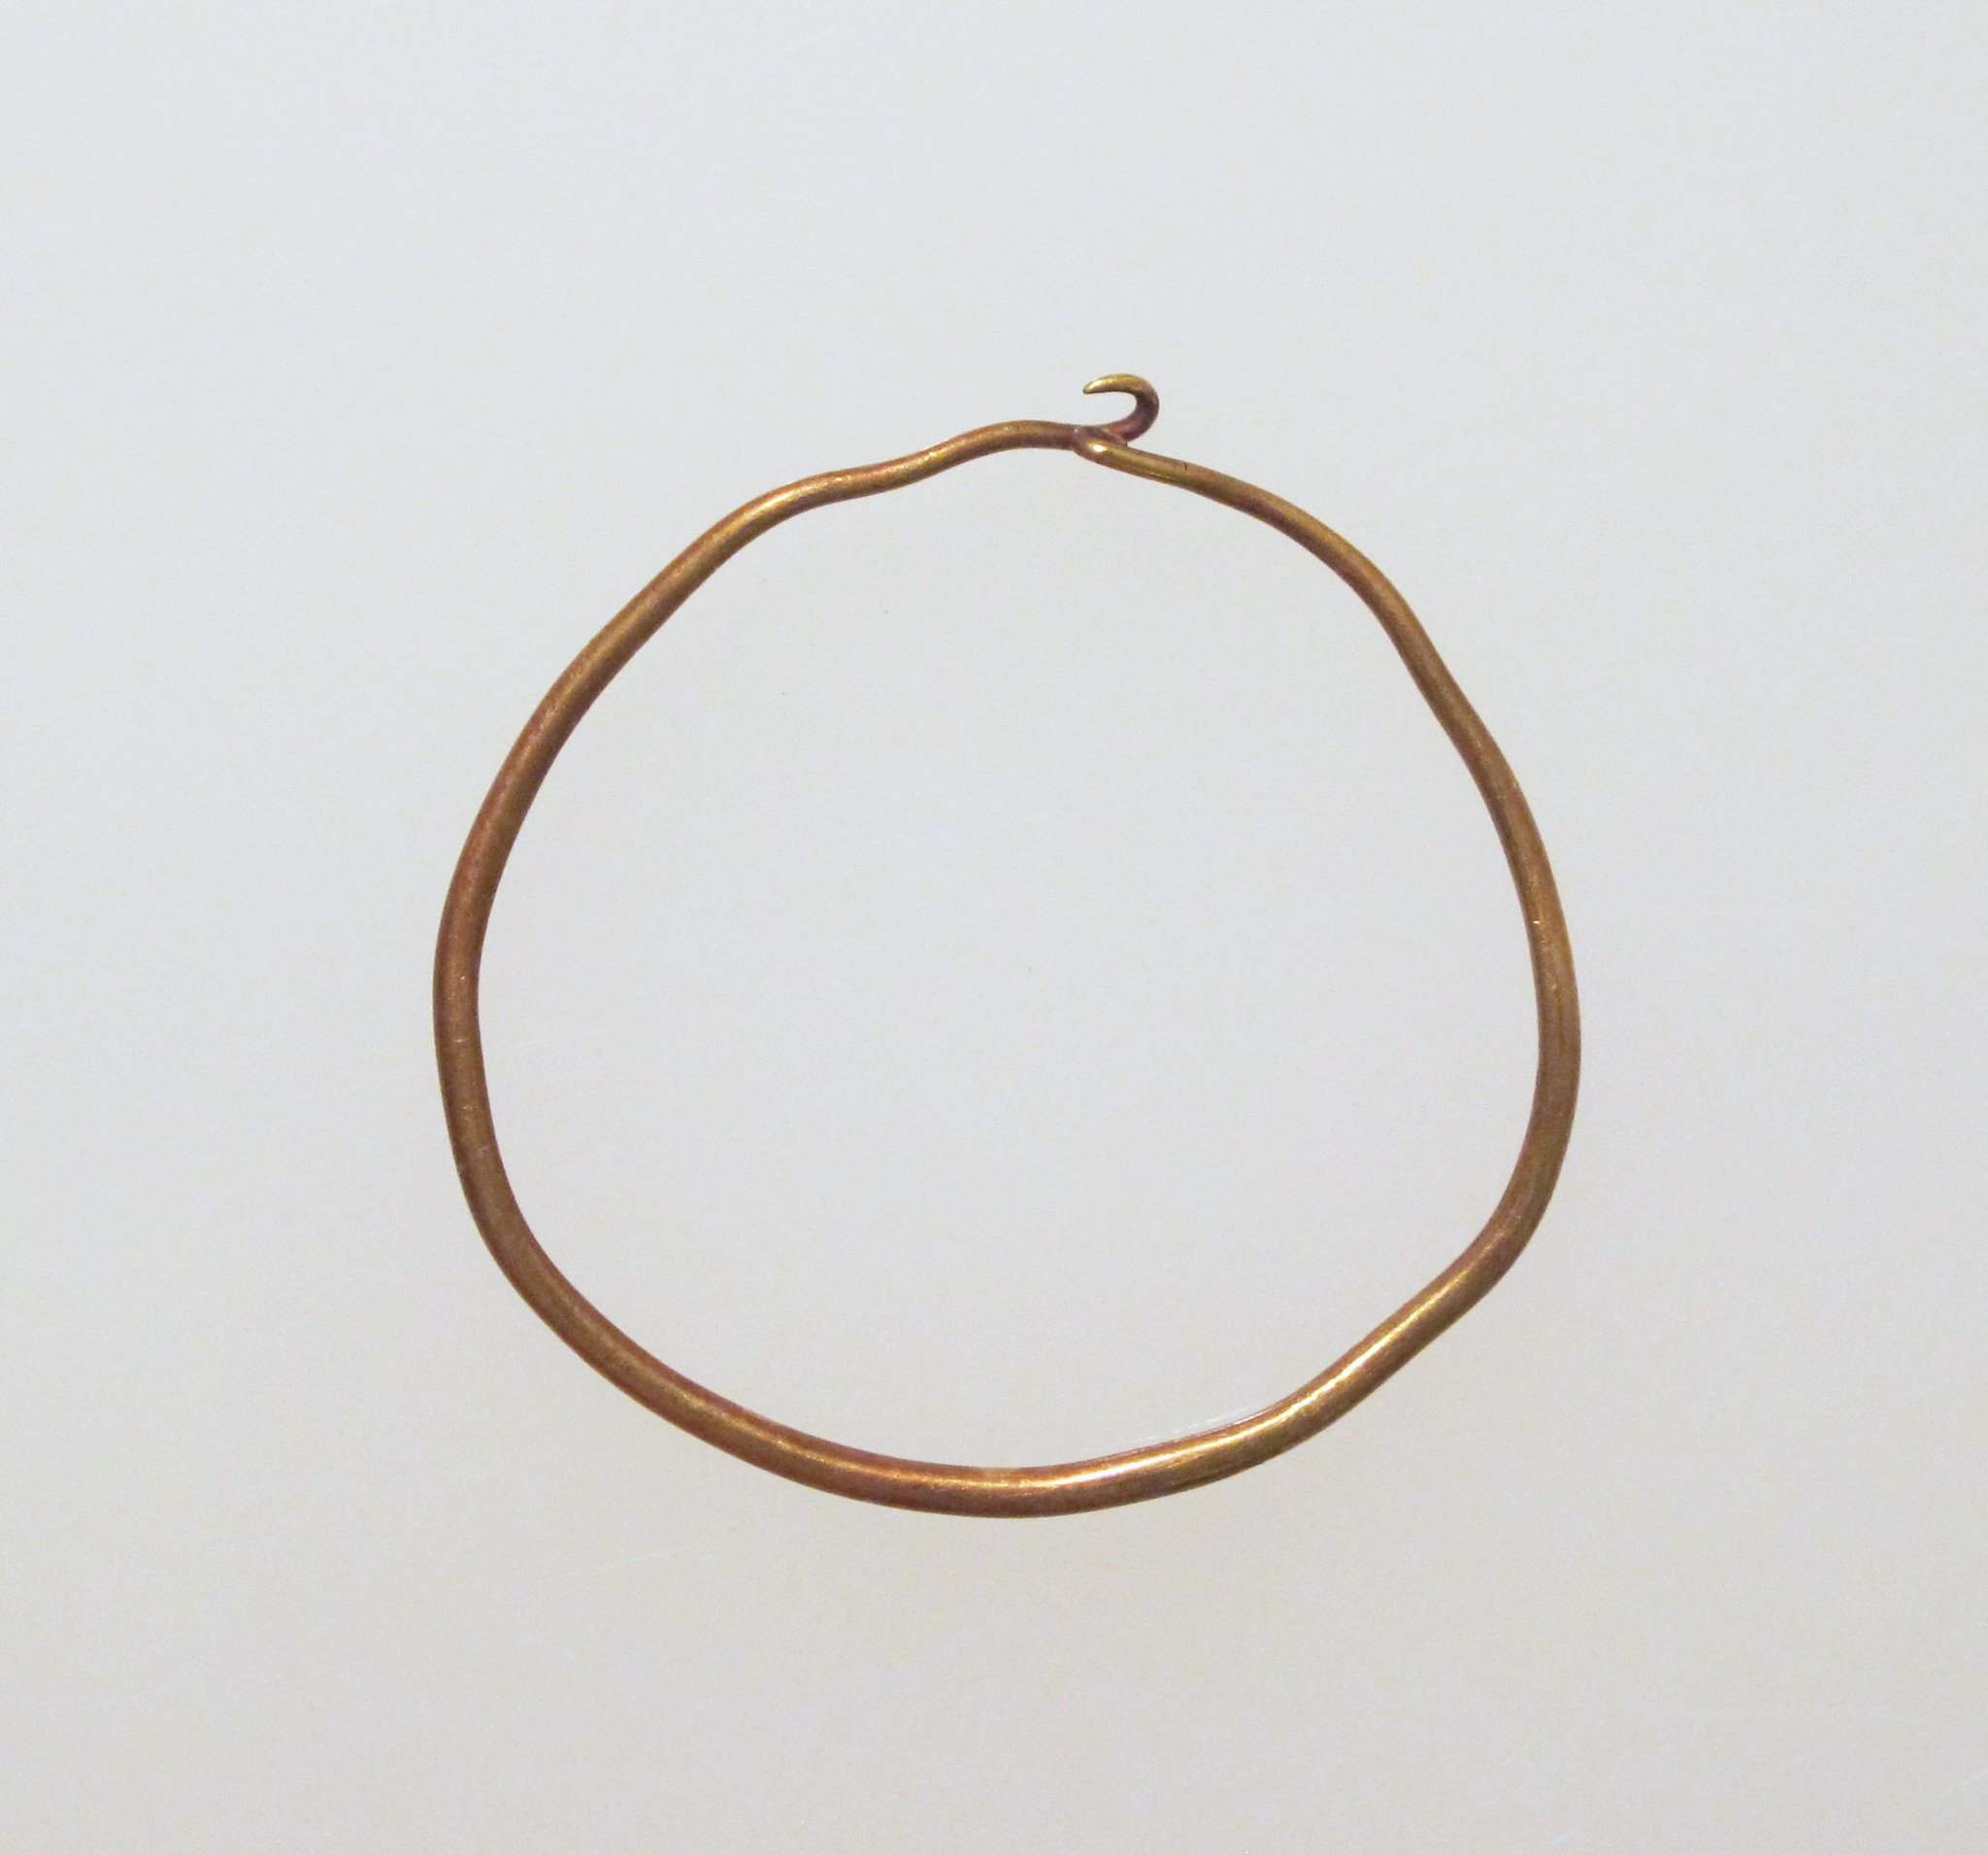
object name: earring loop type, plain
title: Earring-loop type, plain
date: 7000 BCE-330 CE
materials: gold